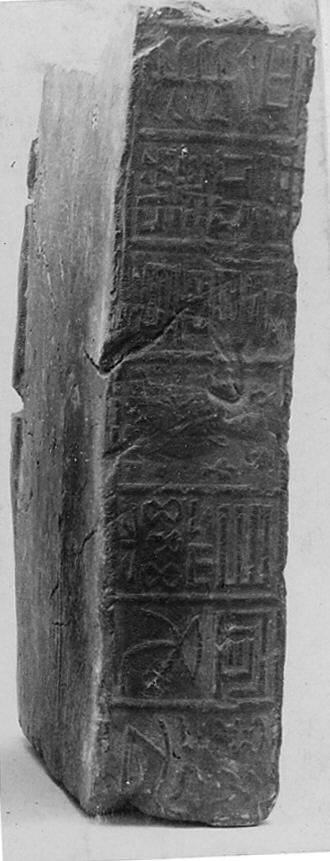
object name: tile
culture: chinese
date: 221 BCE-220 CE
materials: earthenware